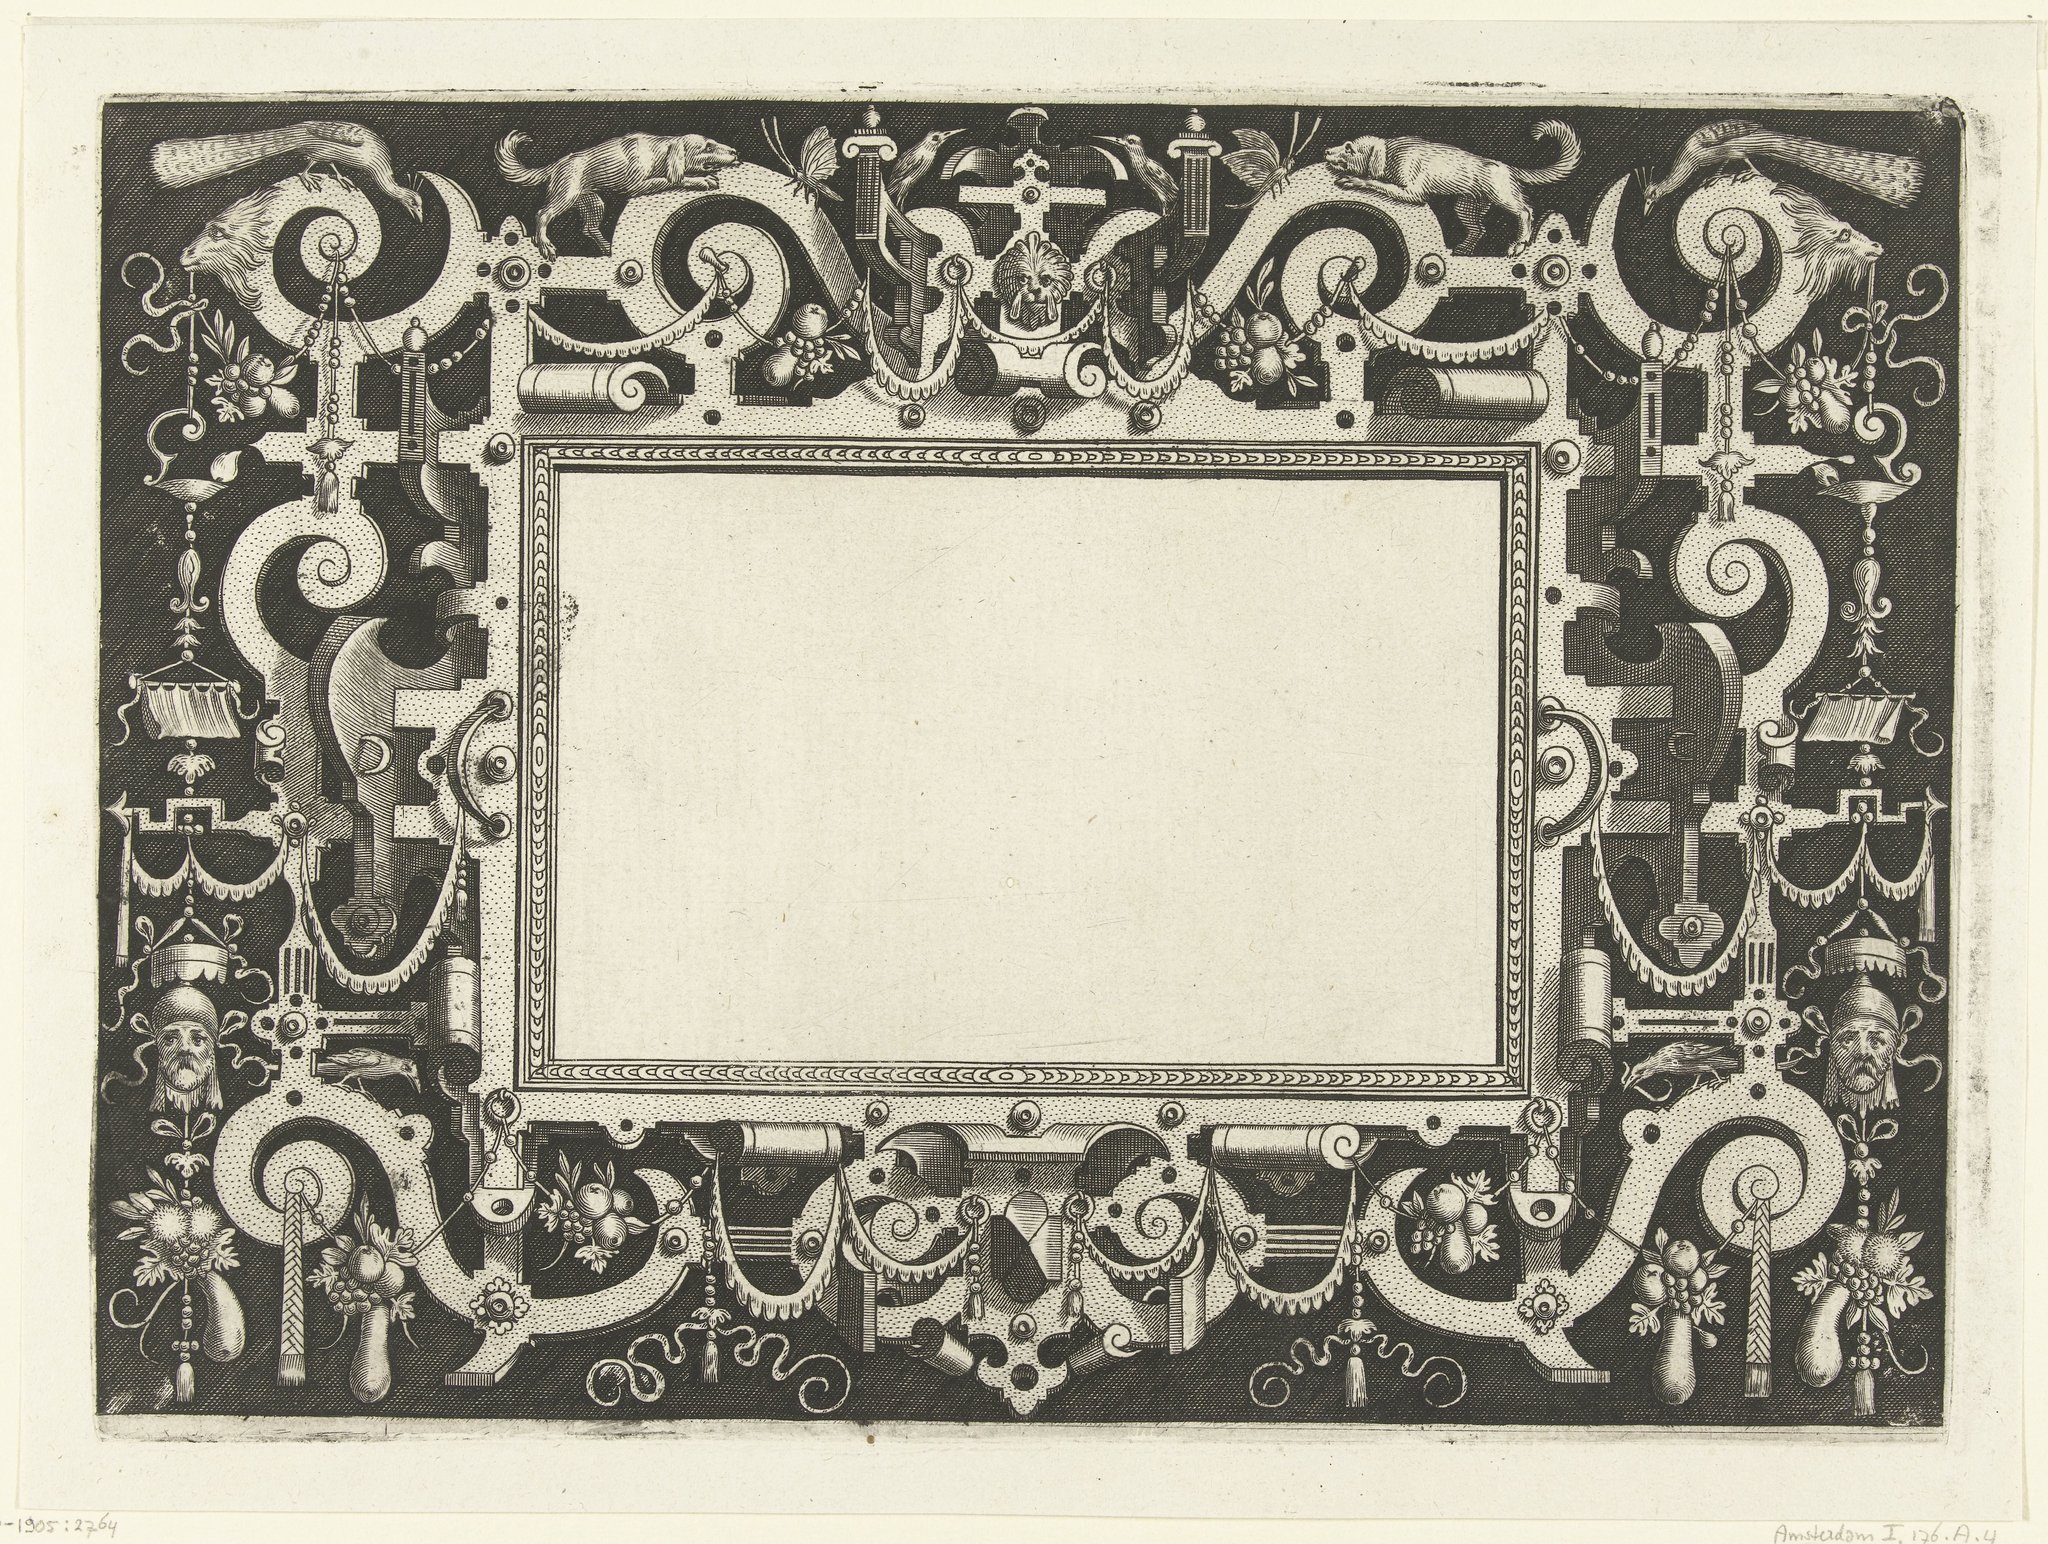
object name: ornament print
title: Cartouche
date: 1581-1635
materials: paper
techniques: etching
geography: netherlands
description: Kopie van blad XXII (Orn Cat I-176.15) uit serie met als titel Exercitatio alphabetica nova et utilissima.... Gearceerde achtergrond. Een van 6 bladen uit een serie van 8?